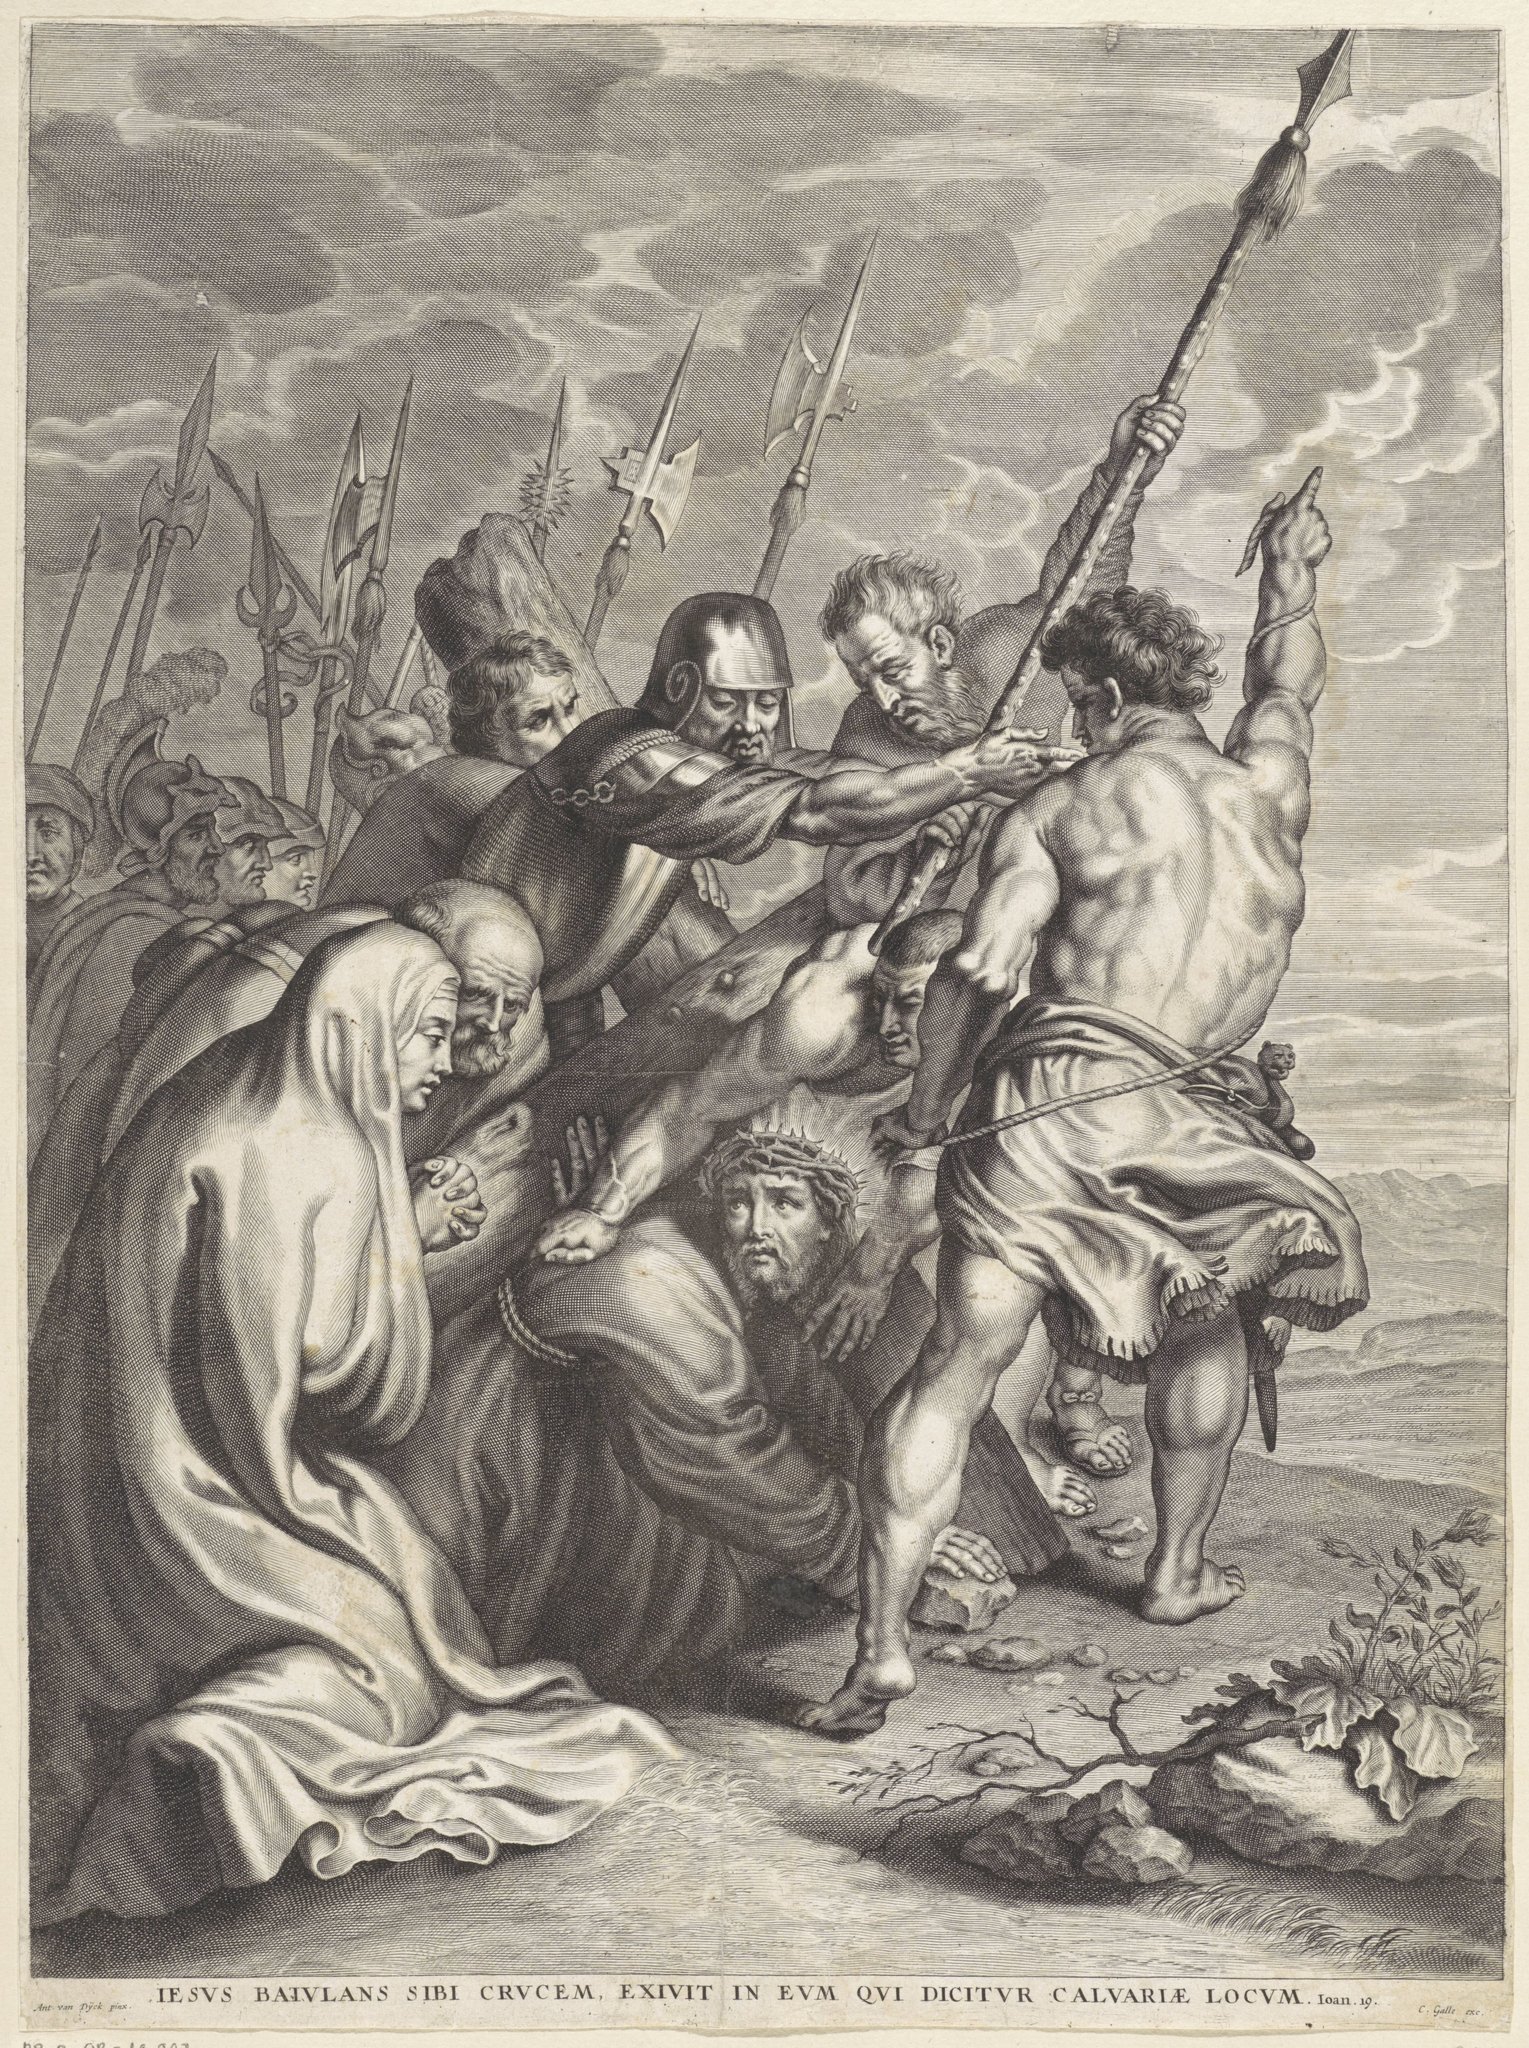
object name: print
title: Kruisdraging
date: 1615-1650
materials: paper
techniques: engraving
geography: low countries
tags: christ collapsing ~ carrying of the cross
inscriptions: collector's mark: Lugt 240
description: Christus valt op weg naar Golgota op zijn knieën onder het gewicht van het kruis. Hij kijkt naar Maria. Rondom hem enkele bewapende soldaten. In de marge een éénregelig onderschrift in het Latijn uit Joh. 19.